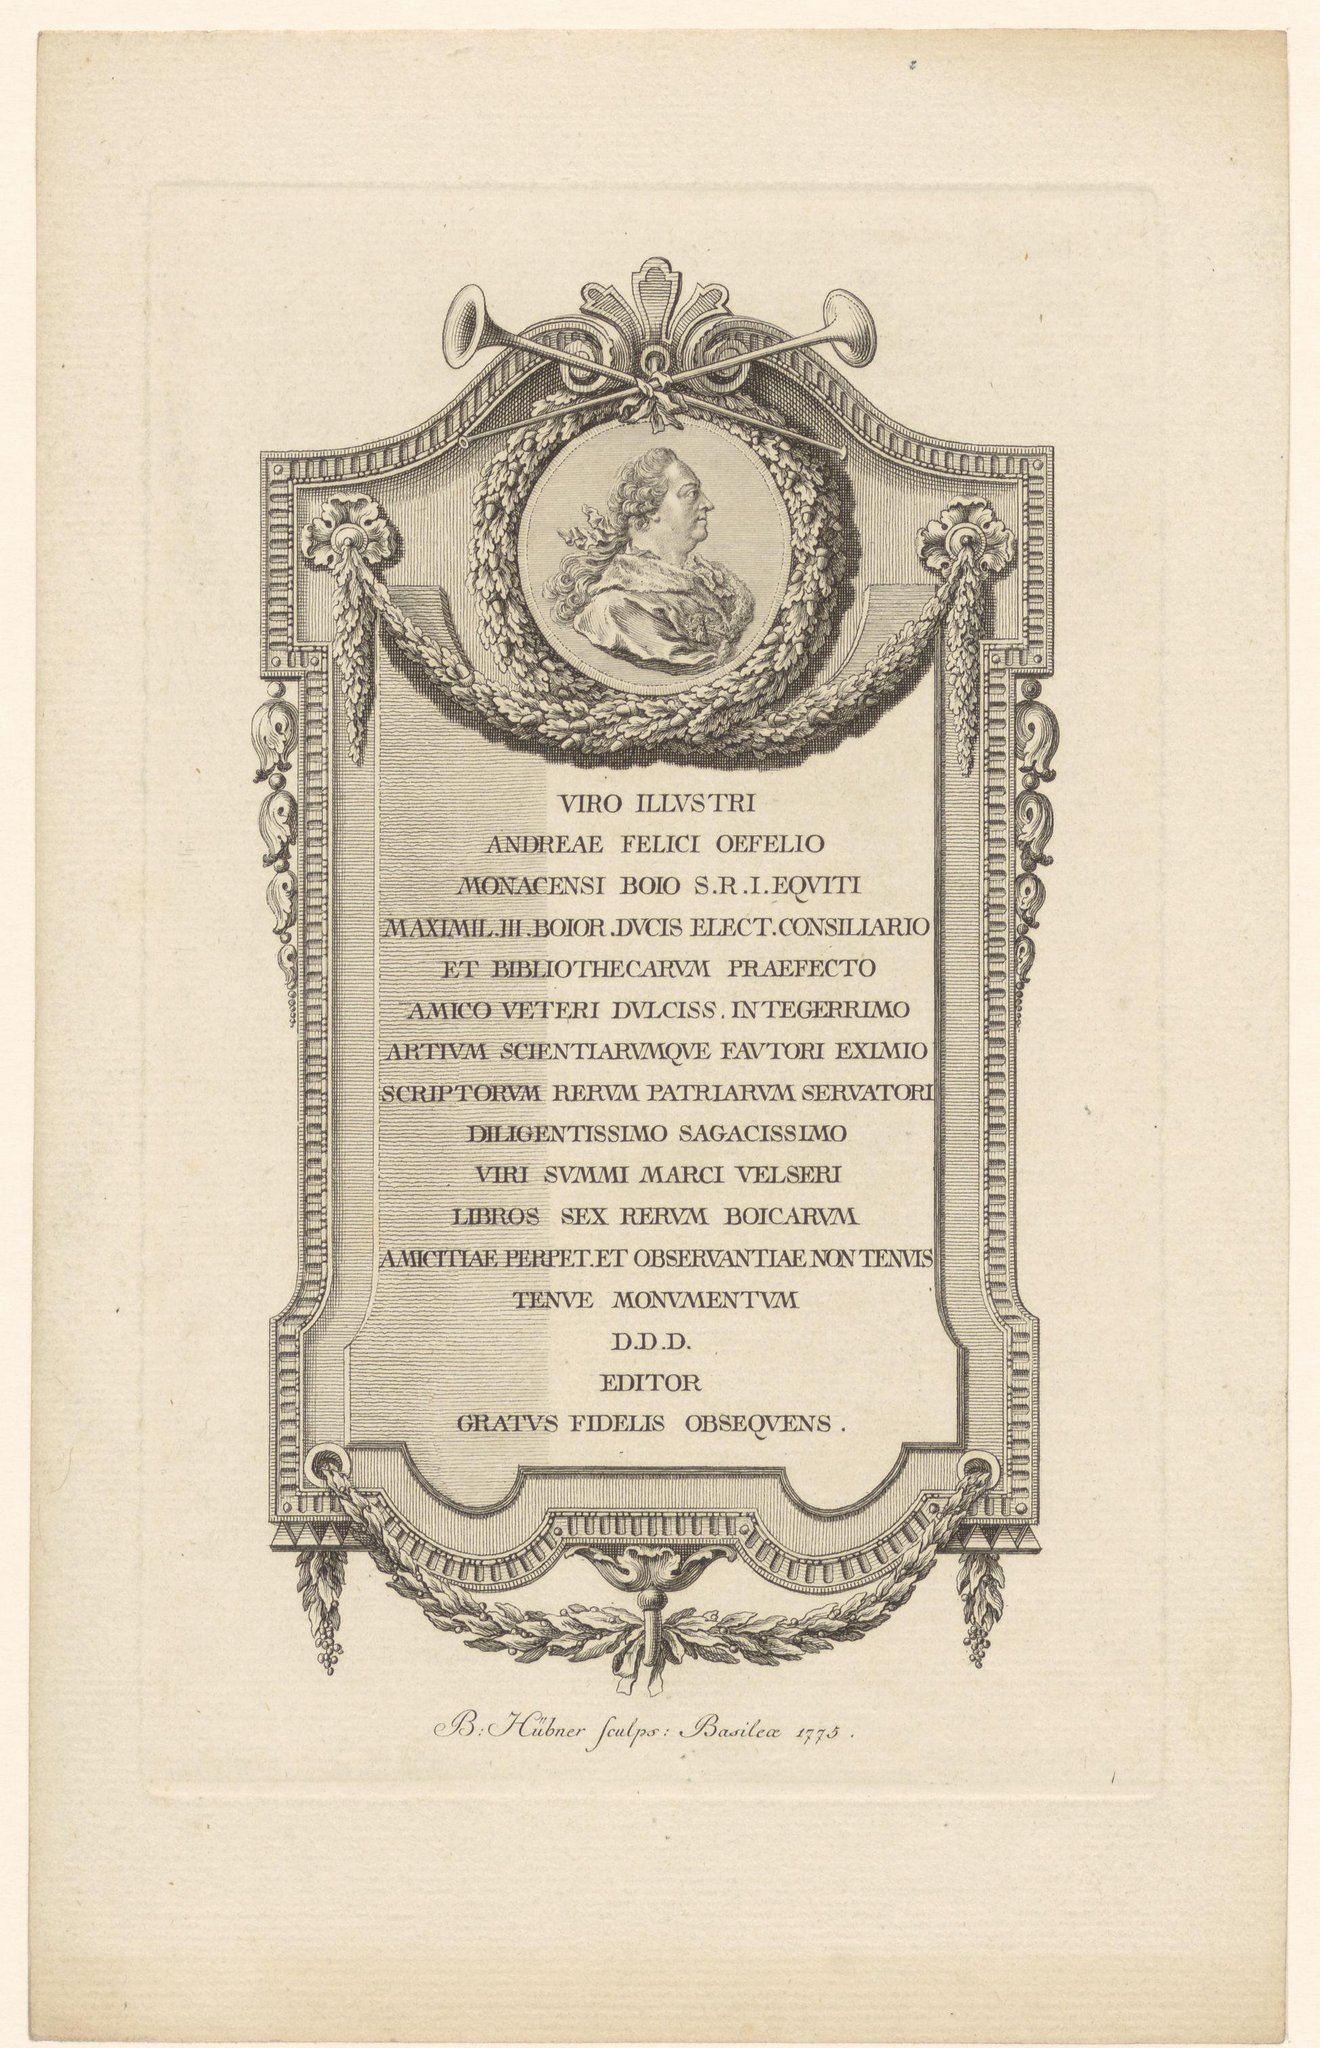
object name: print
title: Portret van Andreas Felix Oefele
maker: bartholomäus hübner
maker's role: print maker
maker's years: 1727-1795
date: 1775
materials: paper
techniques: engraving, etching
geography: basel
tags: horn, trumpet, cornet, trombone, tuba, historical persons, ornament derived from architectural details, ornament ~ festoon, garland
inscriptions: collector's mark: Lugt 2228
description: Portret van Andreas Oefele in rond medaillon en profil naar rechts, boven een plakaat met tekst (lofdicht) in het Latijn.